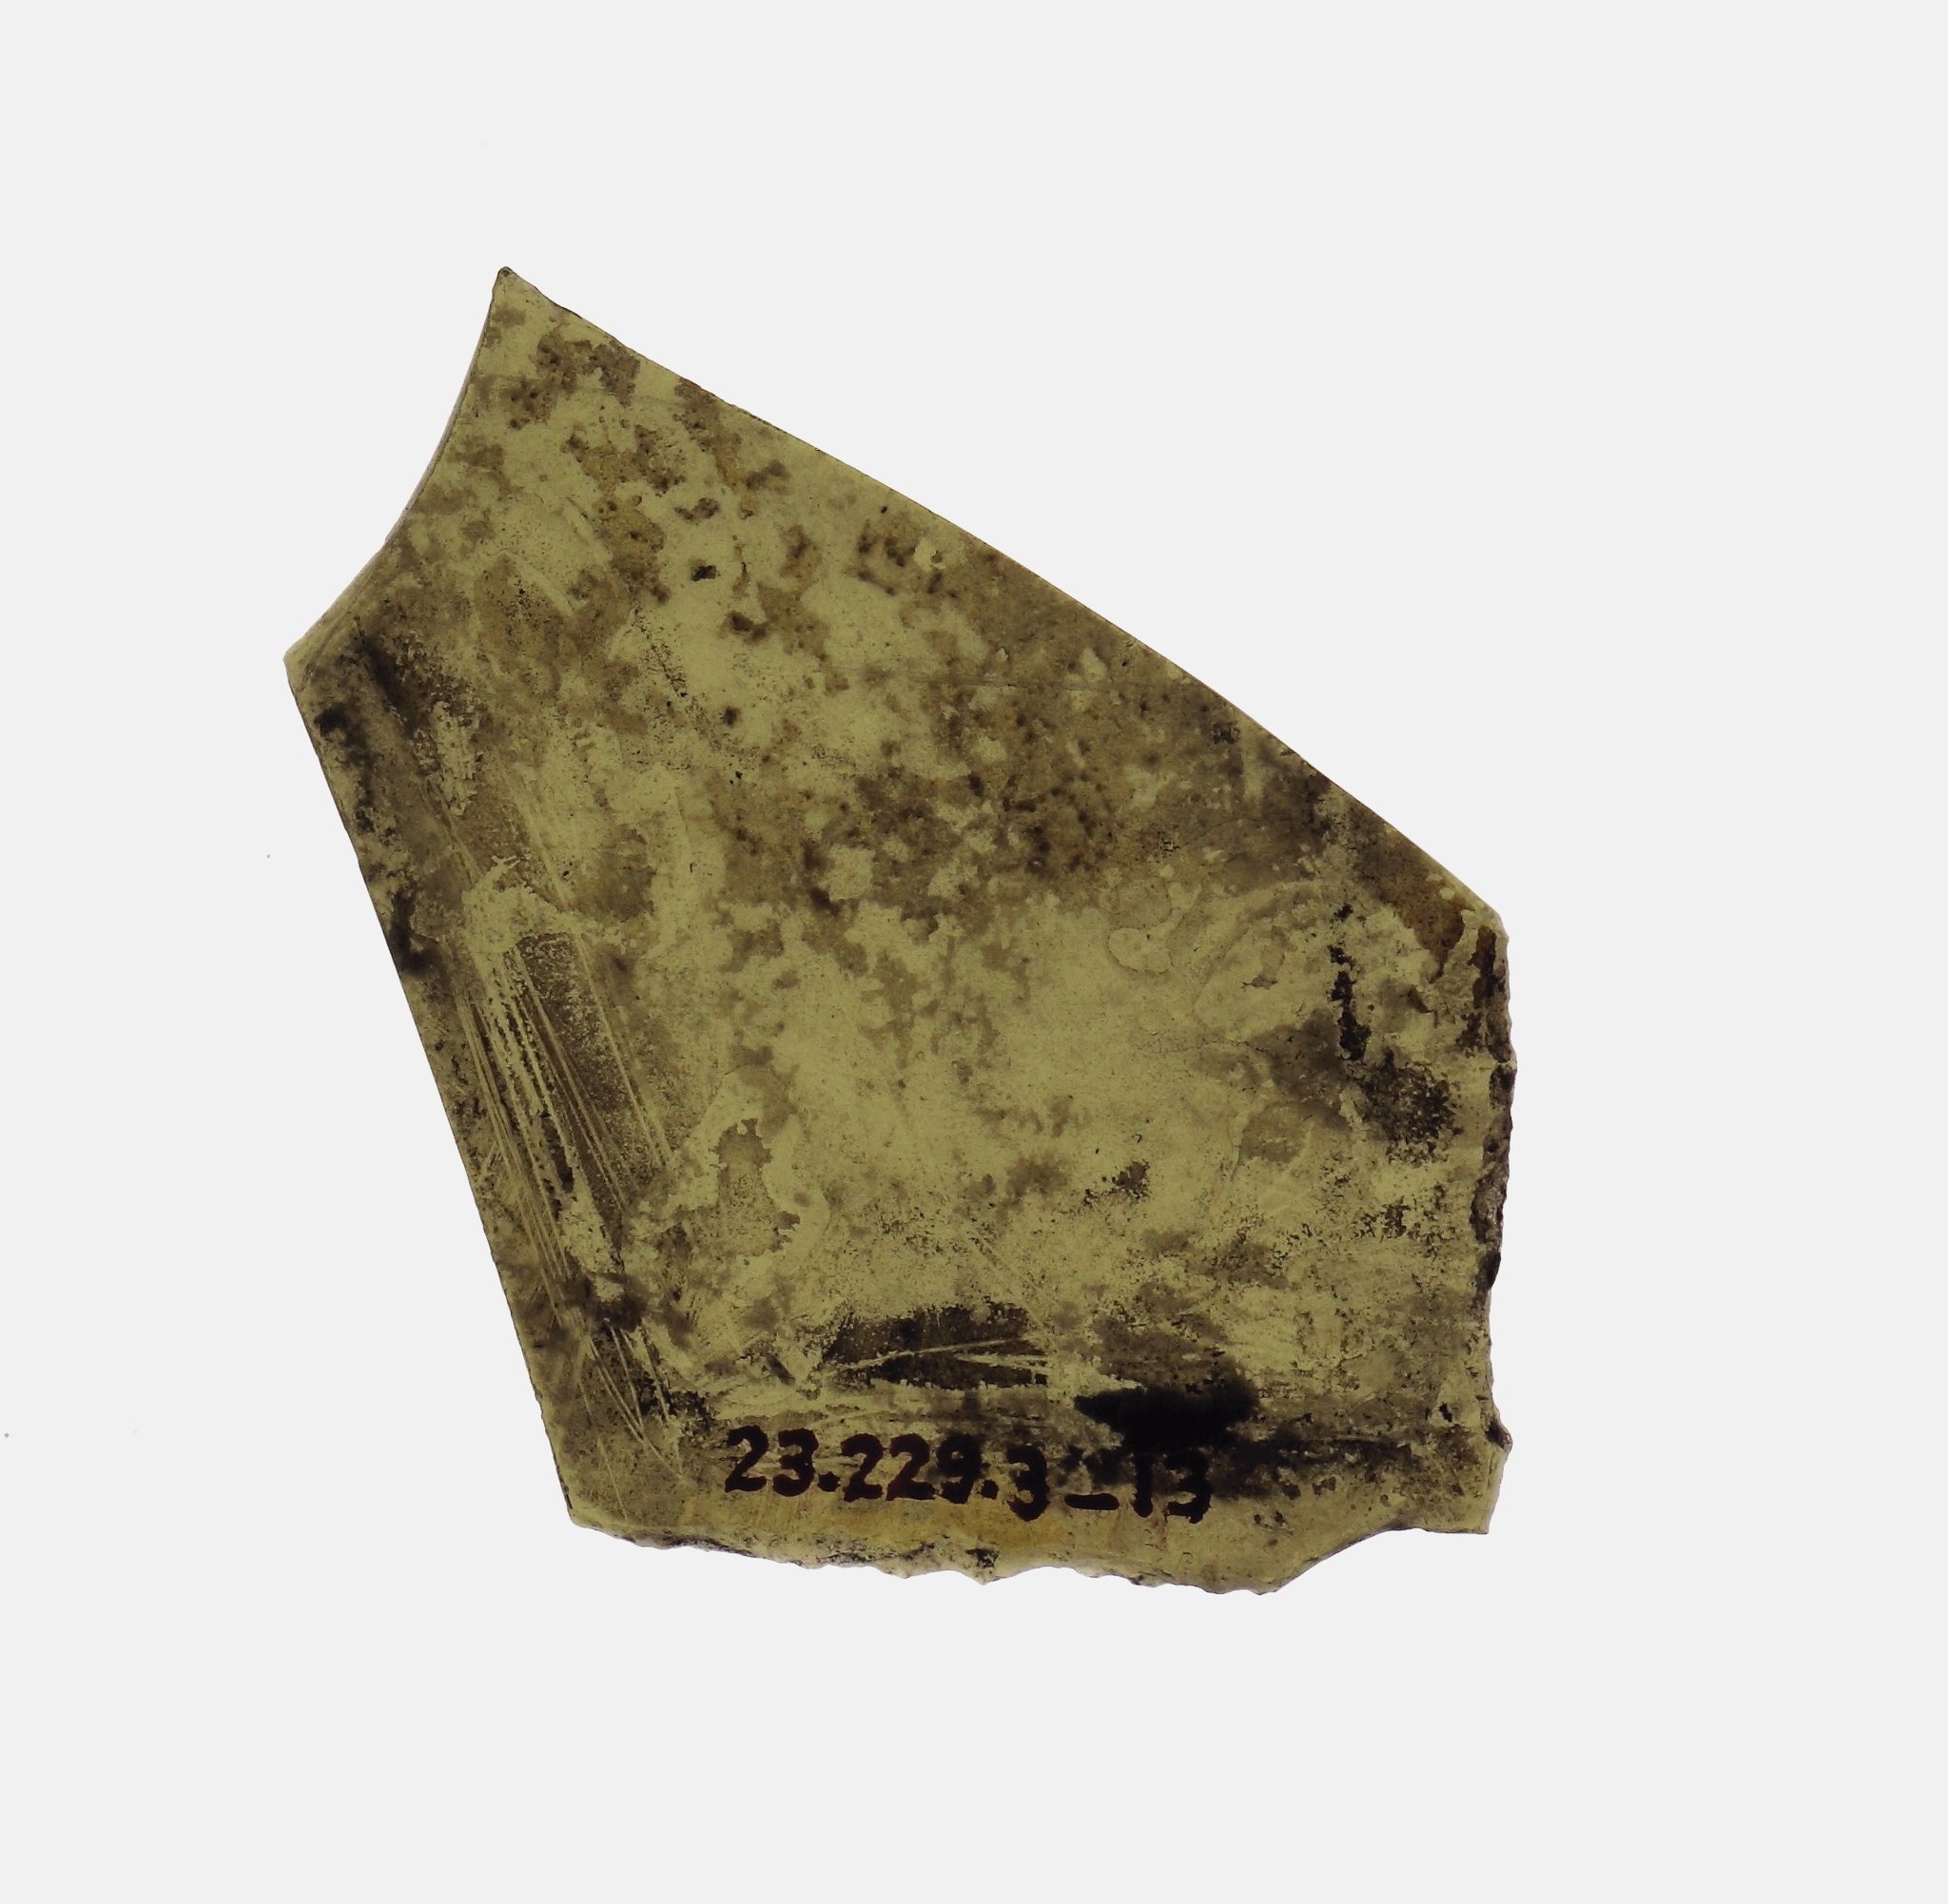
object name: fragment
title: Glass Fragment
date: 1101-1500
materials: glass